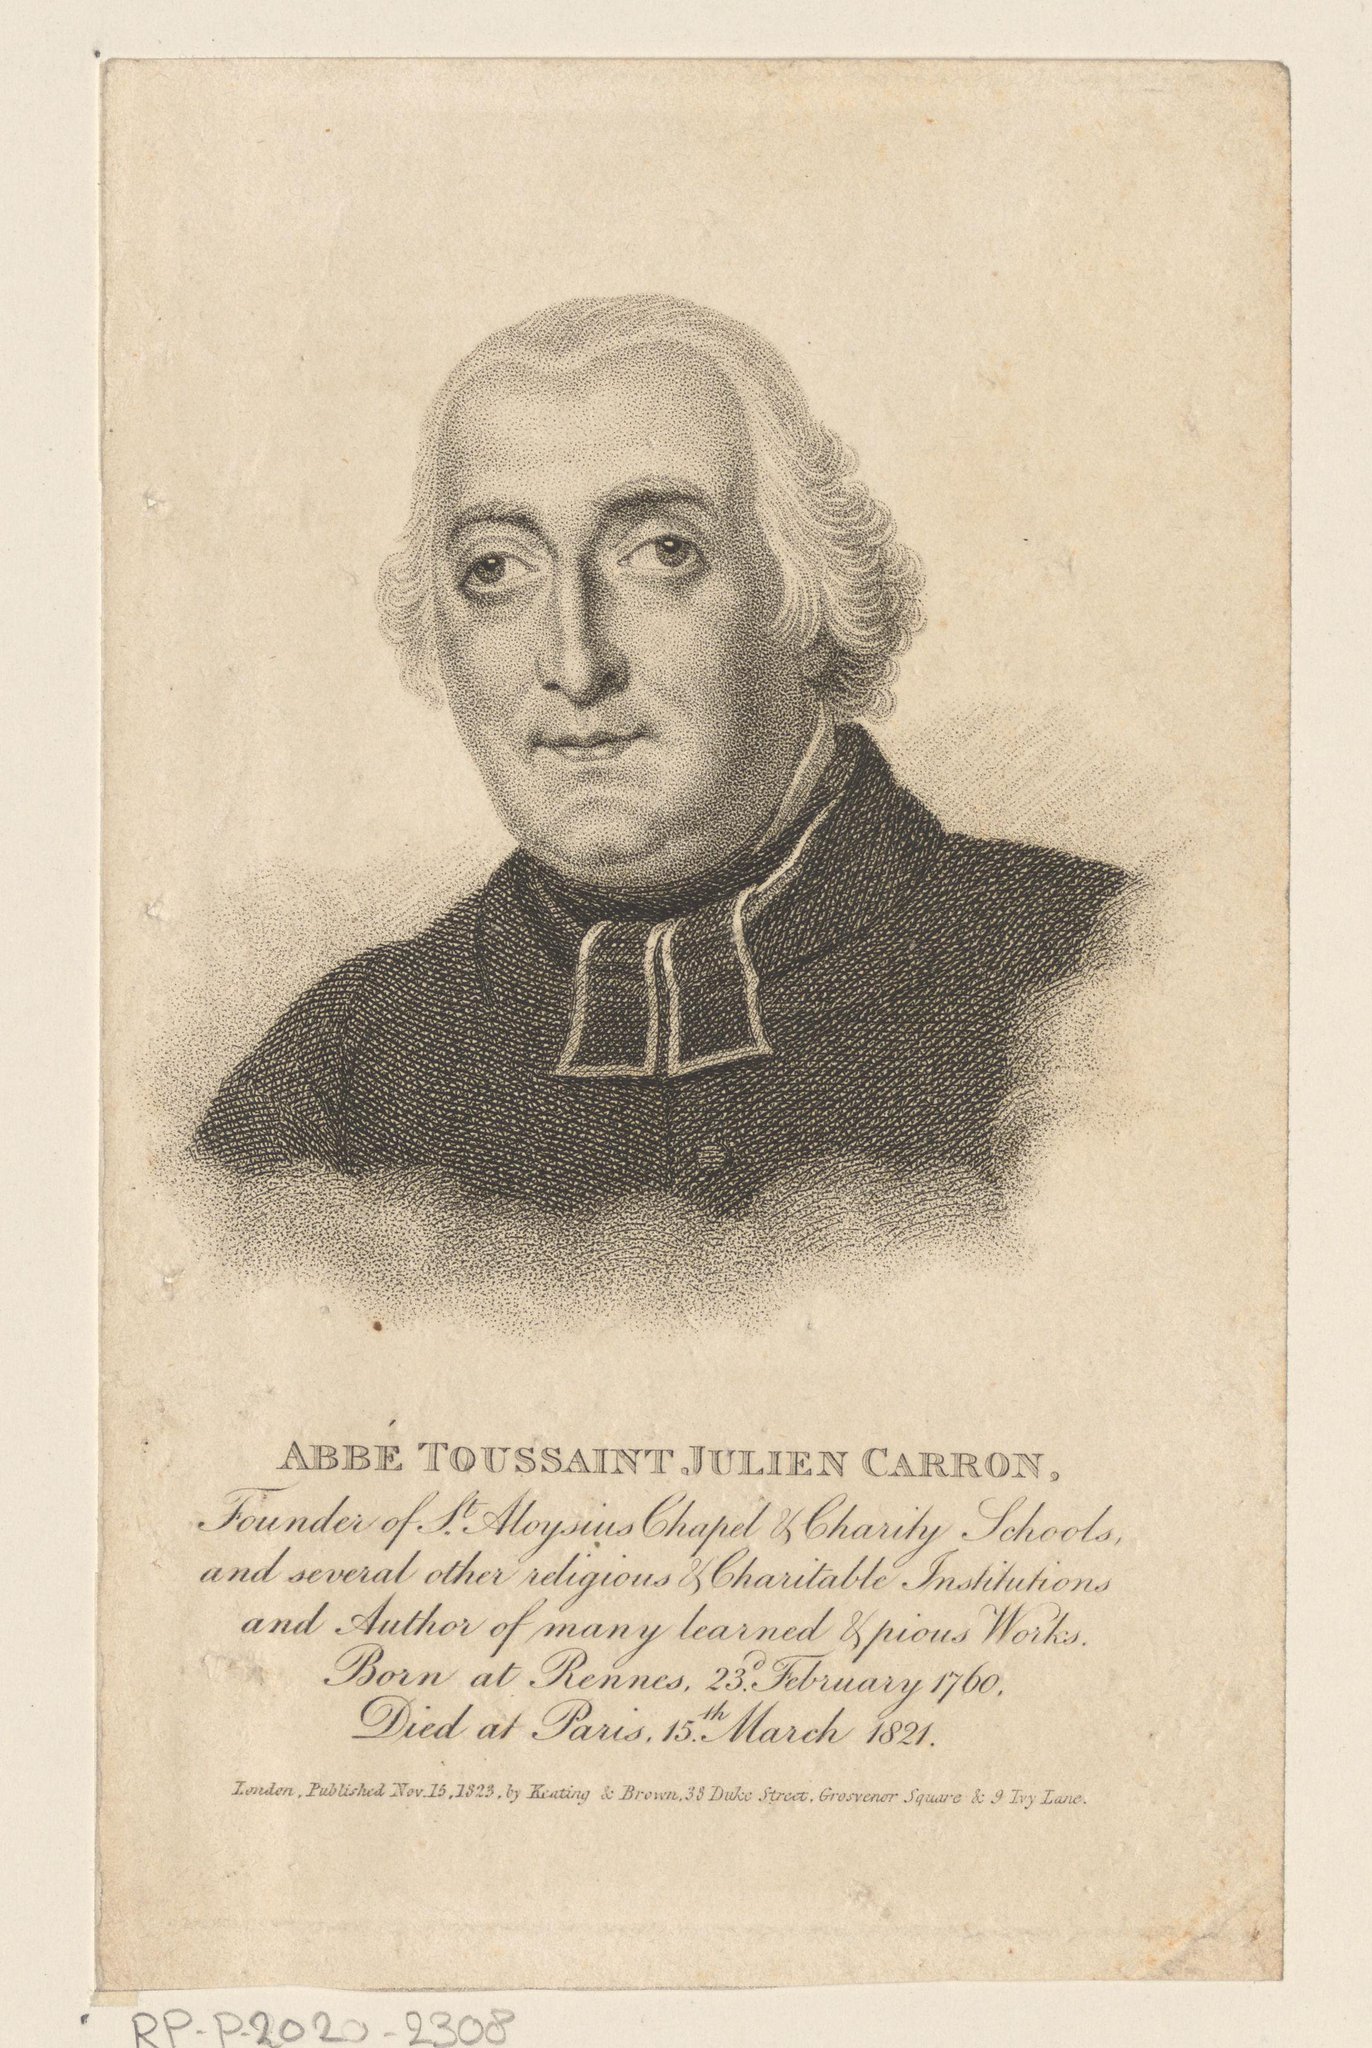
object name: print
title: Portret van Guy-Toussaint-Julien Carron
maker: Anonymous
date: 1800-1820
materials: paper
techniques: engraving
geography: london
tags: paris, priest, historical persons